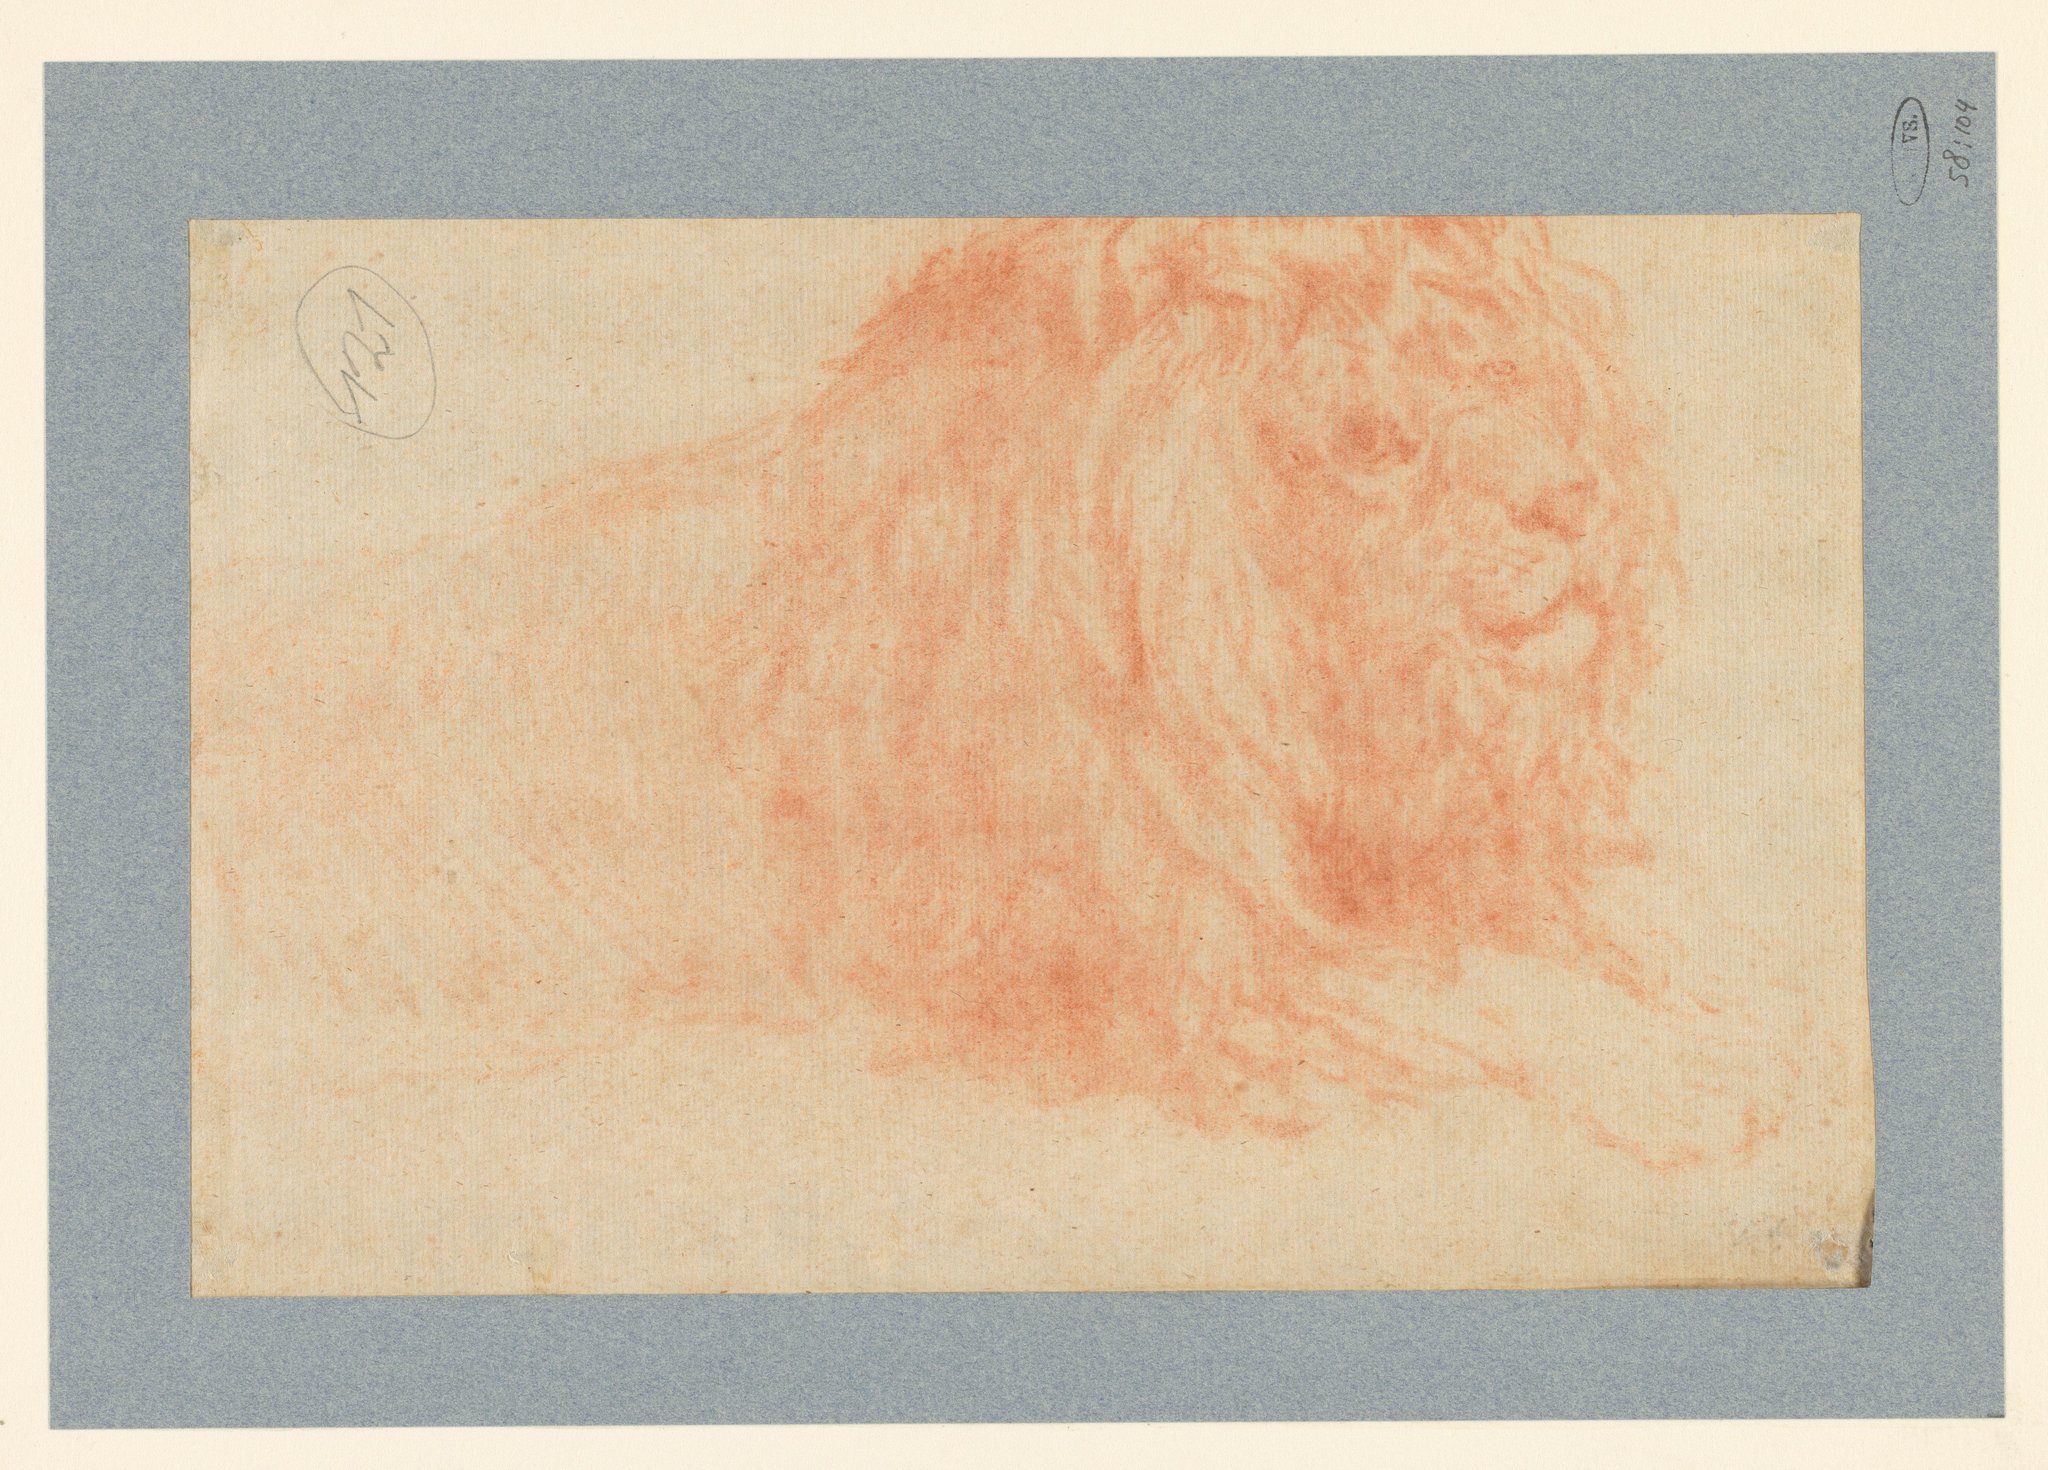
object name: drawing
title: Studie van een leeuw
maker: jean baptiste hilaire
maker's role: draughtsman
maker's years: 1753-1822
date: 1763-1822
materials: chalk, paper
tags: beasts of prey, predatory animals: lion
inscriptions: collector's mark, on the mount, lower righton the mount, lower right: Lugt 2228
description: Doordruk van een (in het boek) volgende studie van een leeuw.